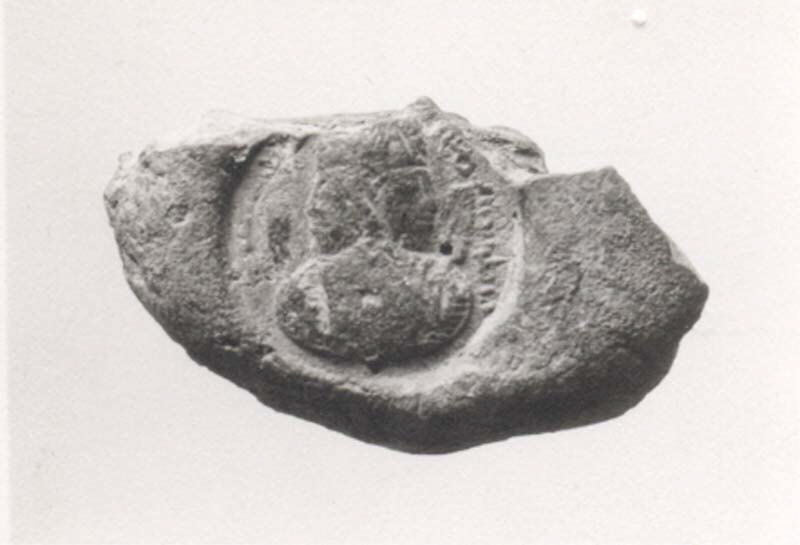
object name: sealing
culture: sasanian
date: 601-700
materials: clay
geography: iran